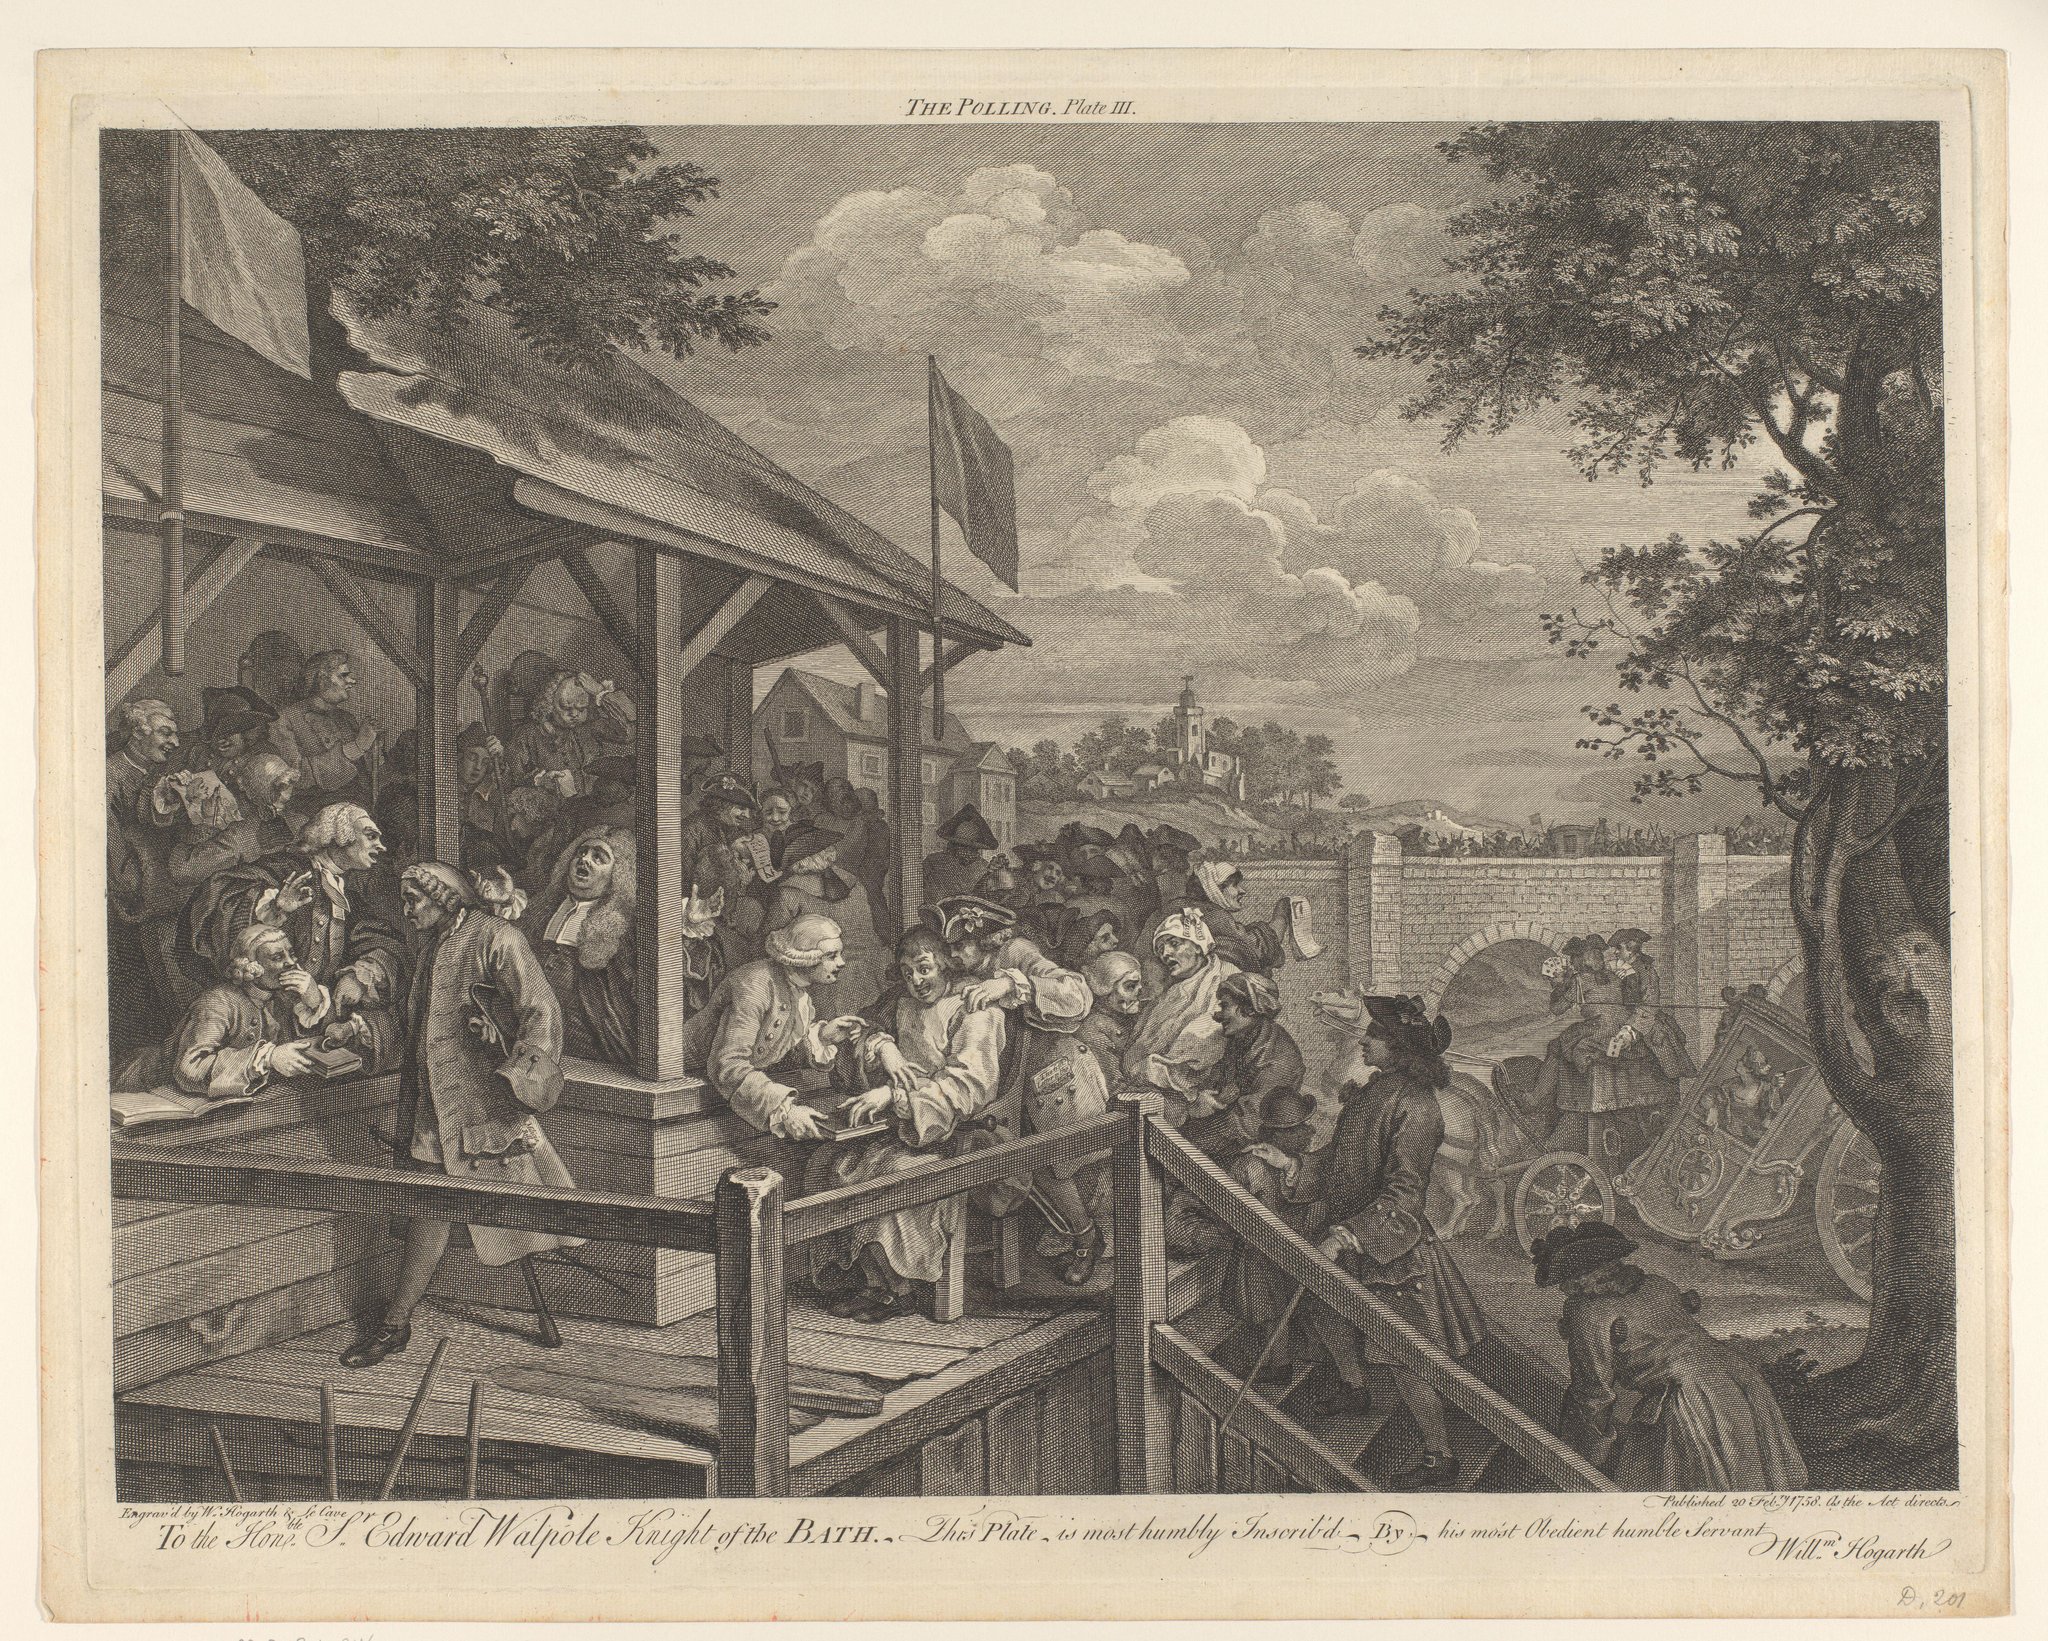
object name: print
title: The Polling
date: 1702-1758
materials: paper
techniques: engraving, etching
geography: london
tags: accident with four-wheeled, animal-drawn vehicle, e.g.: cab, carriage, coach, voting, election, personifications of countries, nations, states, districts, etc., crutches, wooden leg, laughing, patient, sick person, playing-cards, skin and venereal diseases: syphilis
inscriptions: collector's mark: Lugt 2228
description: Mensen met een beperking en zieke mensen worden op een podium gebracht om hun stem uit te brengen. Achter hen onder een overkapping lachen anderen om een portret van een kandidaat en een nieuwsbericht over een executie. Rechts stort een koets met een afbeelding van de Union Jack in. De vrouwelijke passagier, Britannia, probeert de aandacht de trekken van de koetsiers, maar die zijn druk bezig met kaarten.